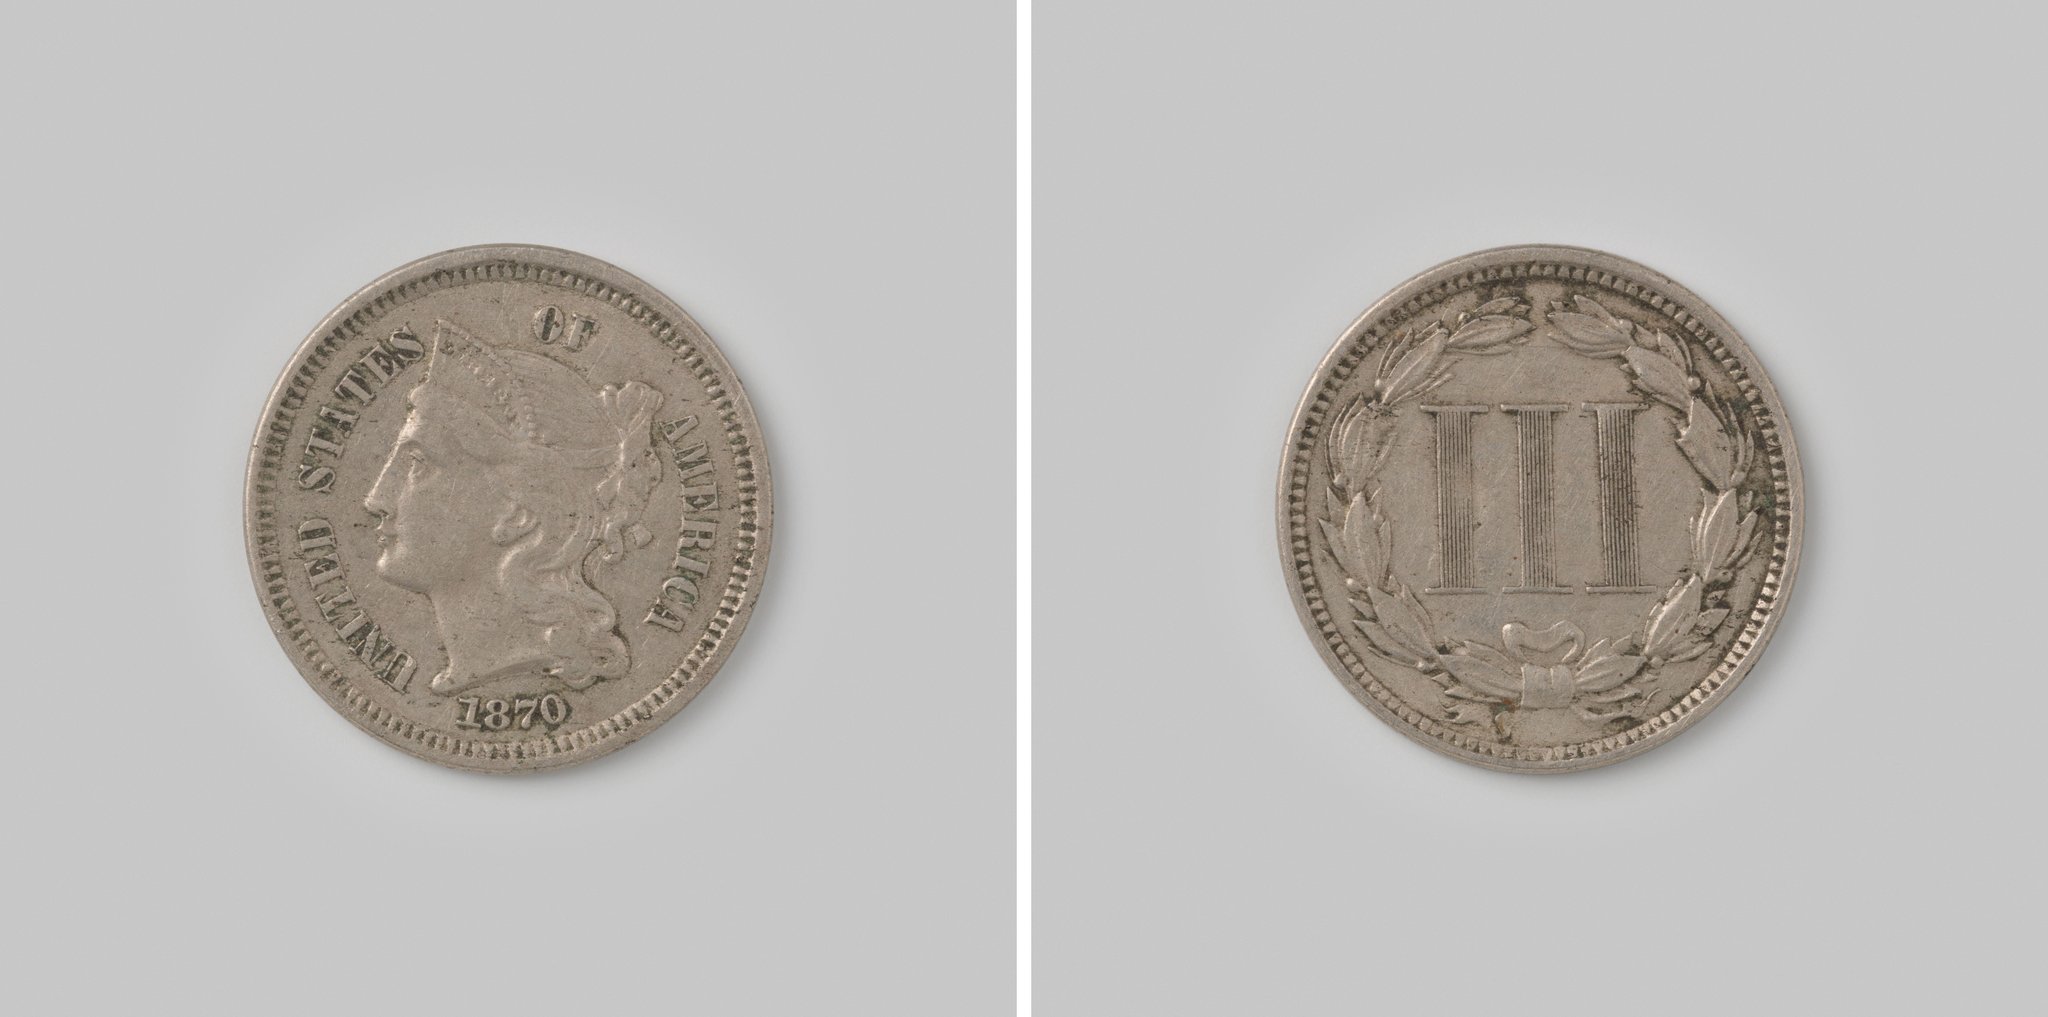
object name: coin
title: Verenigde Staten van Amerika, 3 cents, 1870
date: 1870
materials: nickel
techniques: striking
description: Koper-nikkelen munt. Voorzijde: Hoofd (coronet head) naar links, waaronder jaartal. Keerzijde: tussen twee samengebonden takken waarde-aanduiding: III. Gladde rand.